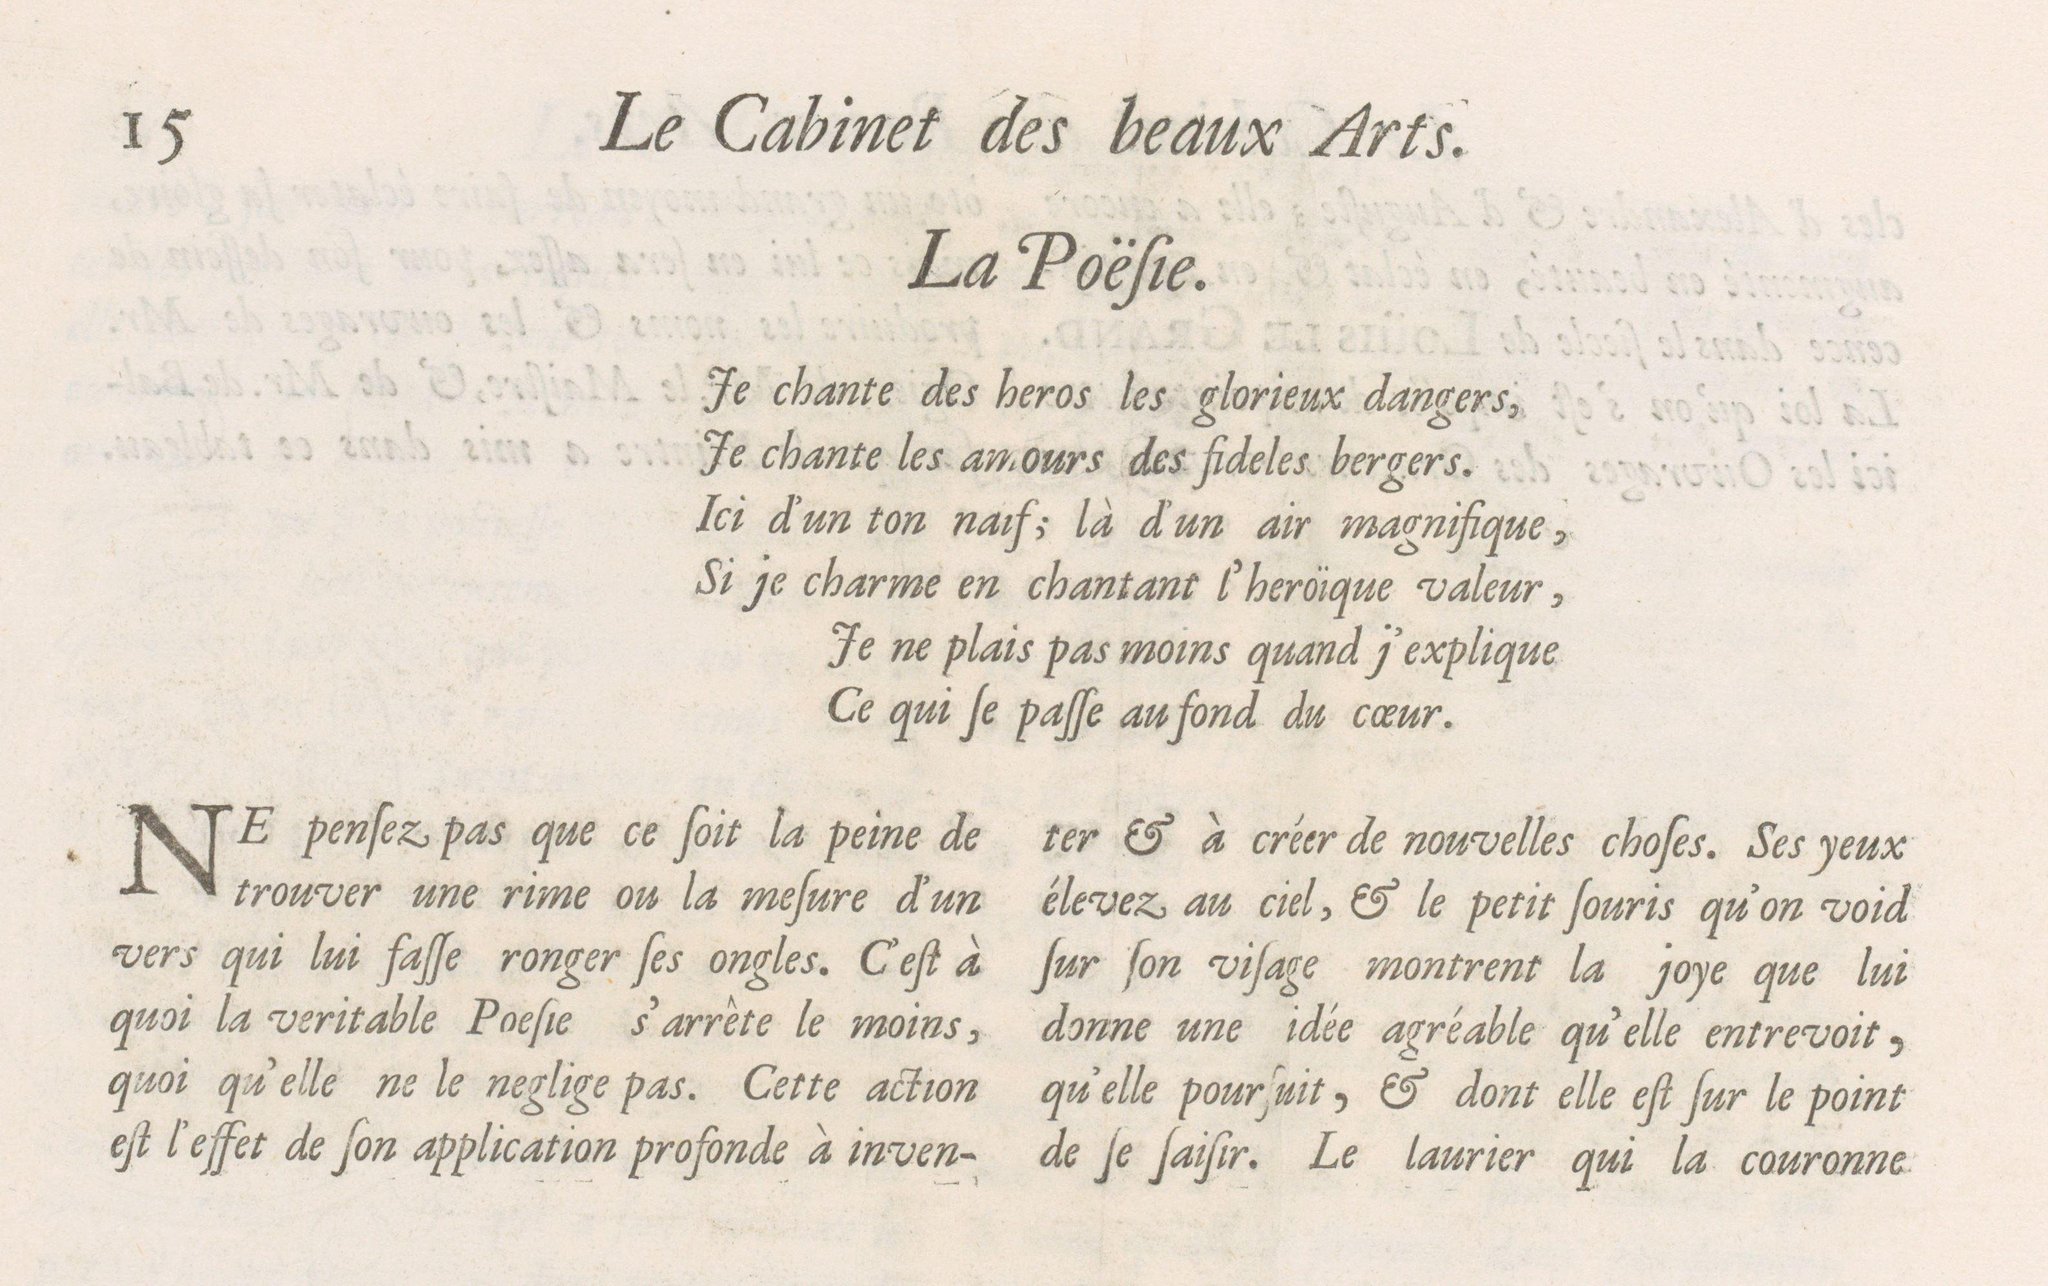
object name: text sheet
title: La Poësie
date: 1695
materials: paper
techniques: letterpress printing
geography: paris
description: Verklaring van de prent met voorstelling van Poëzie of Dichtkunst in het Frans. Pagina 15. Tekstblad maakt deel uit van een album.